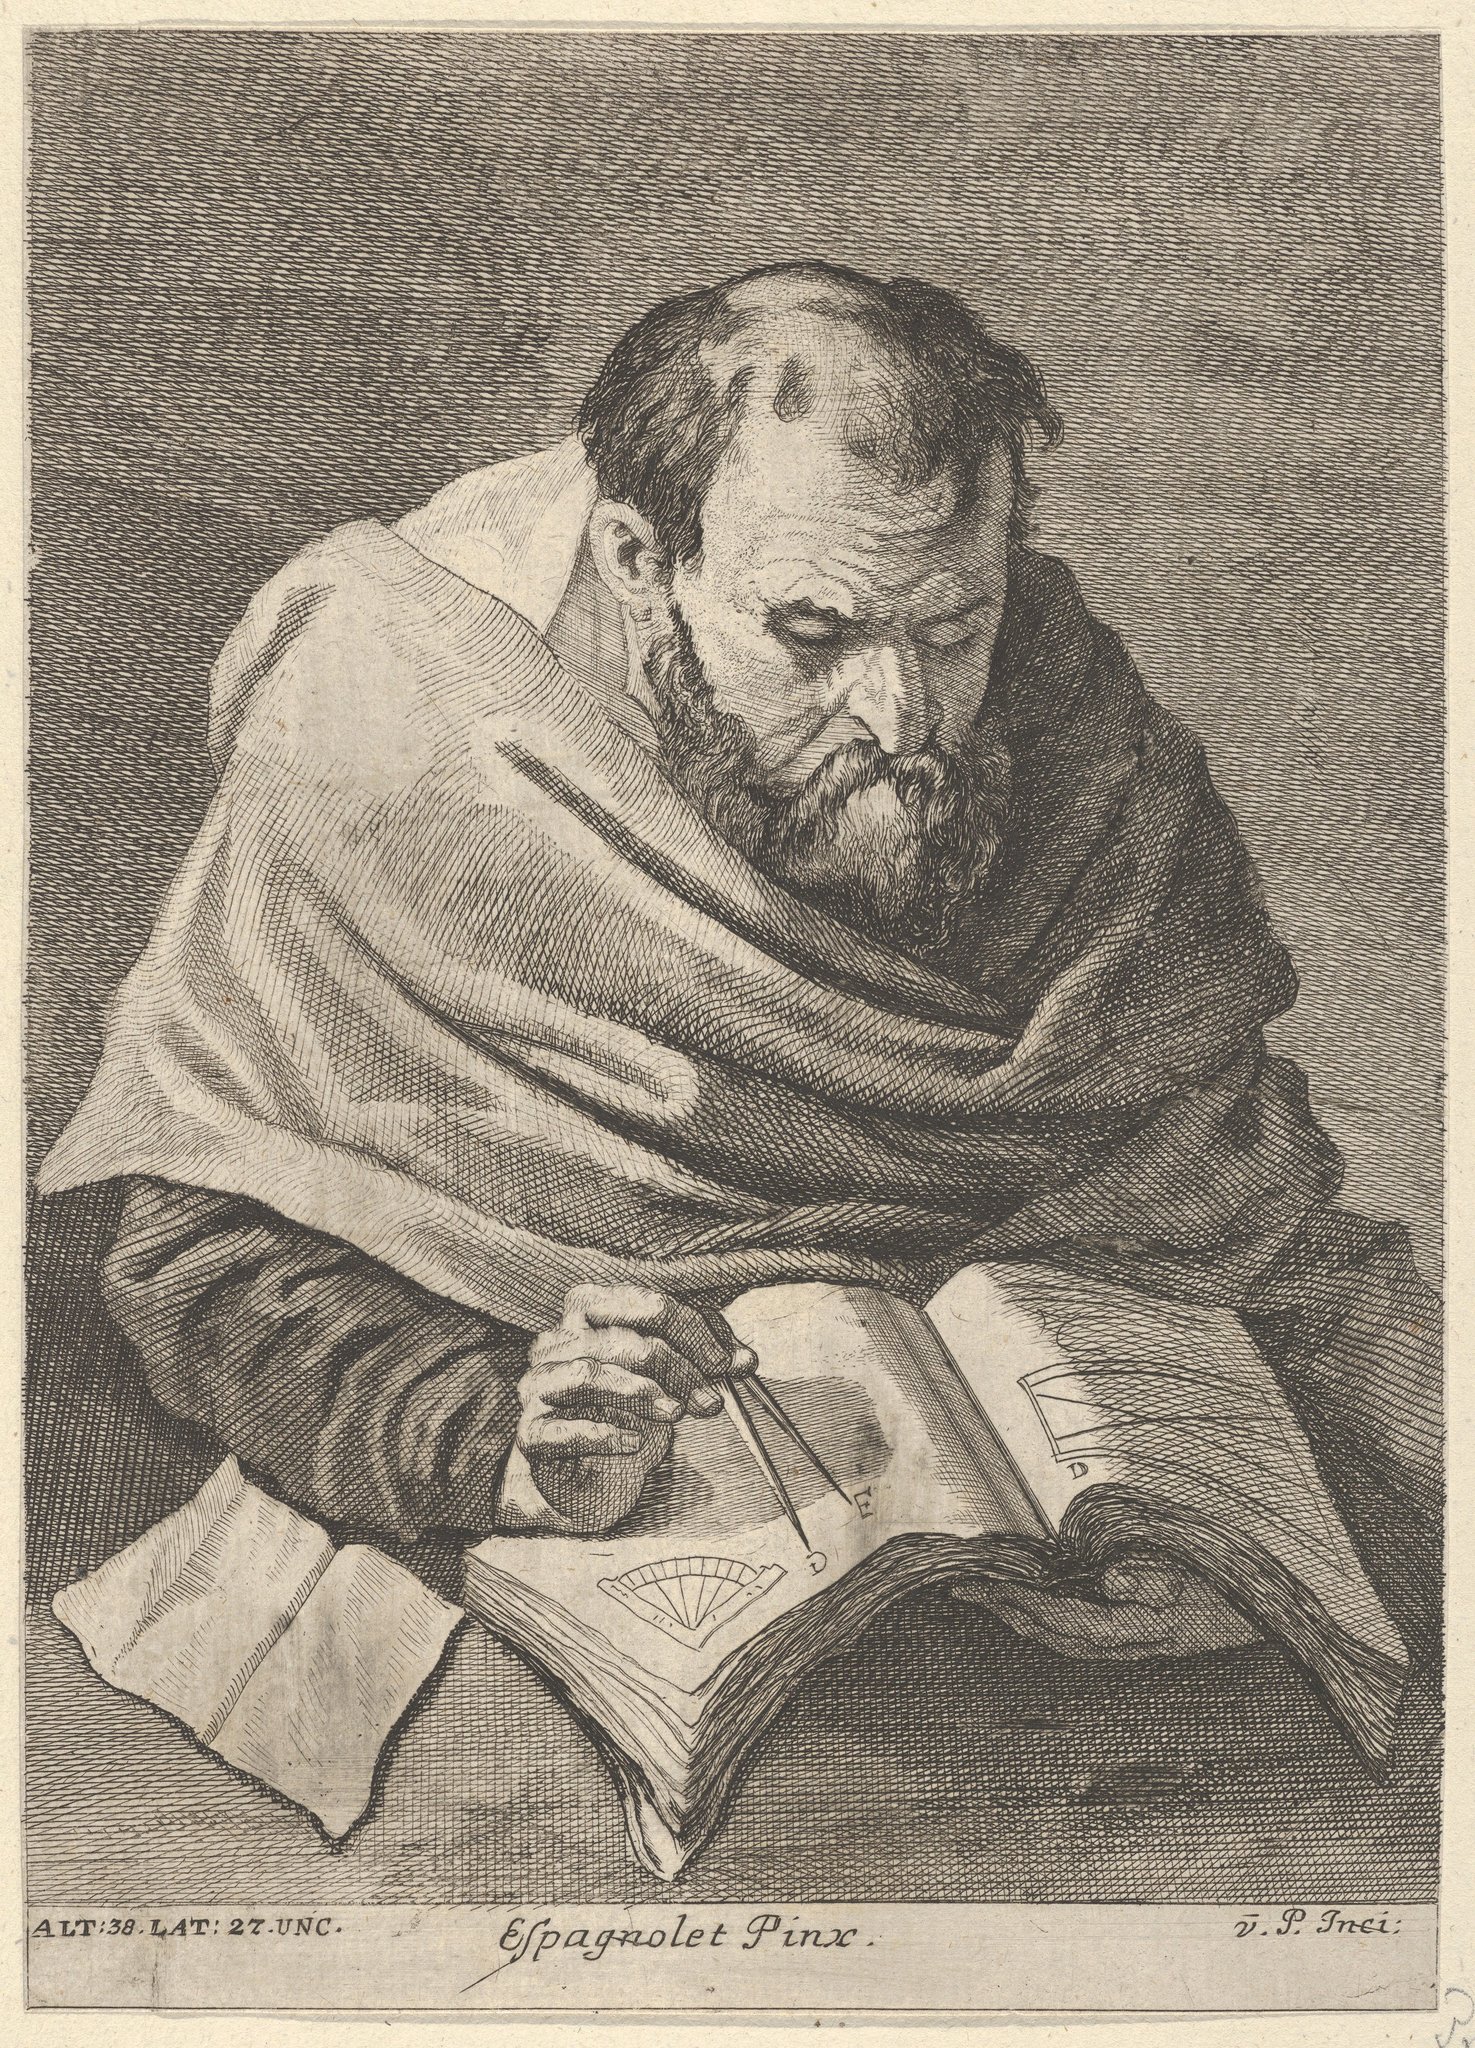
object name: print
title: A mathematician seated at a table, working on mathematical equations, from a portfolio of prints of the Imperial Gallery of Paintings in Vienna; plate 34 of the series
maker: anton joseph von prenner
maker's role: artist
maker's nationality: austrian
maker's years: 1683-1761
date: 1728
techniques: etching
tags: men,geometry